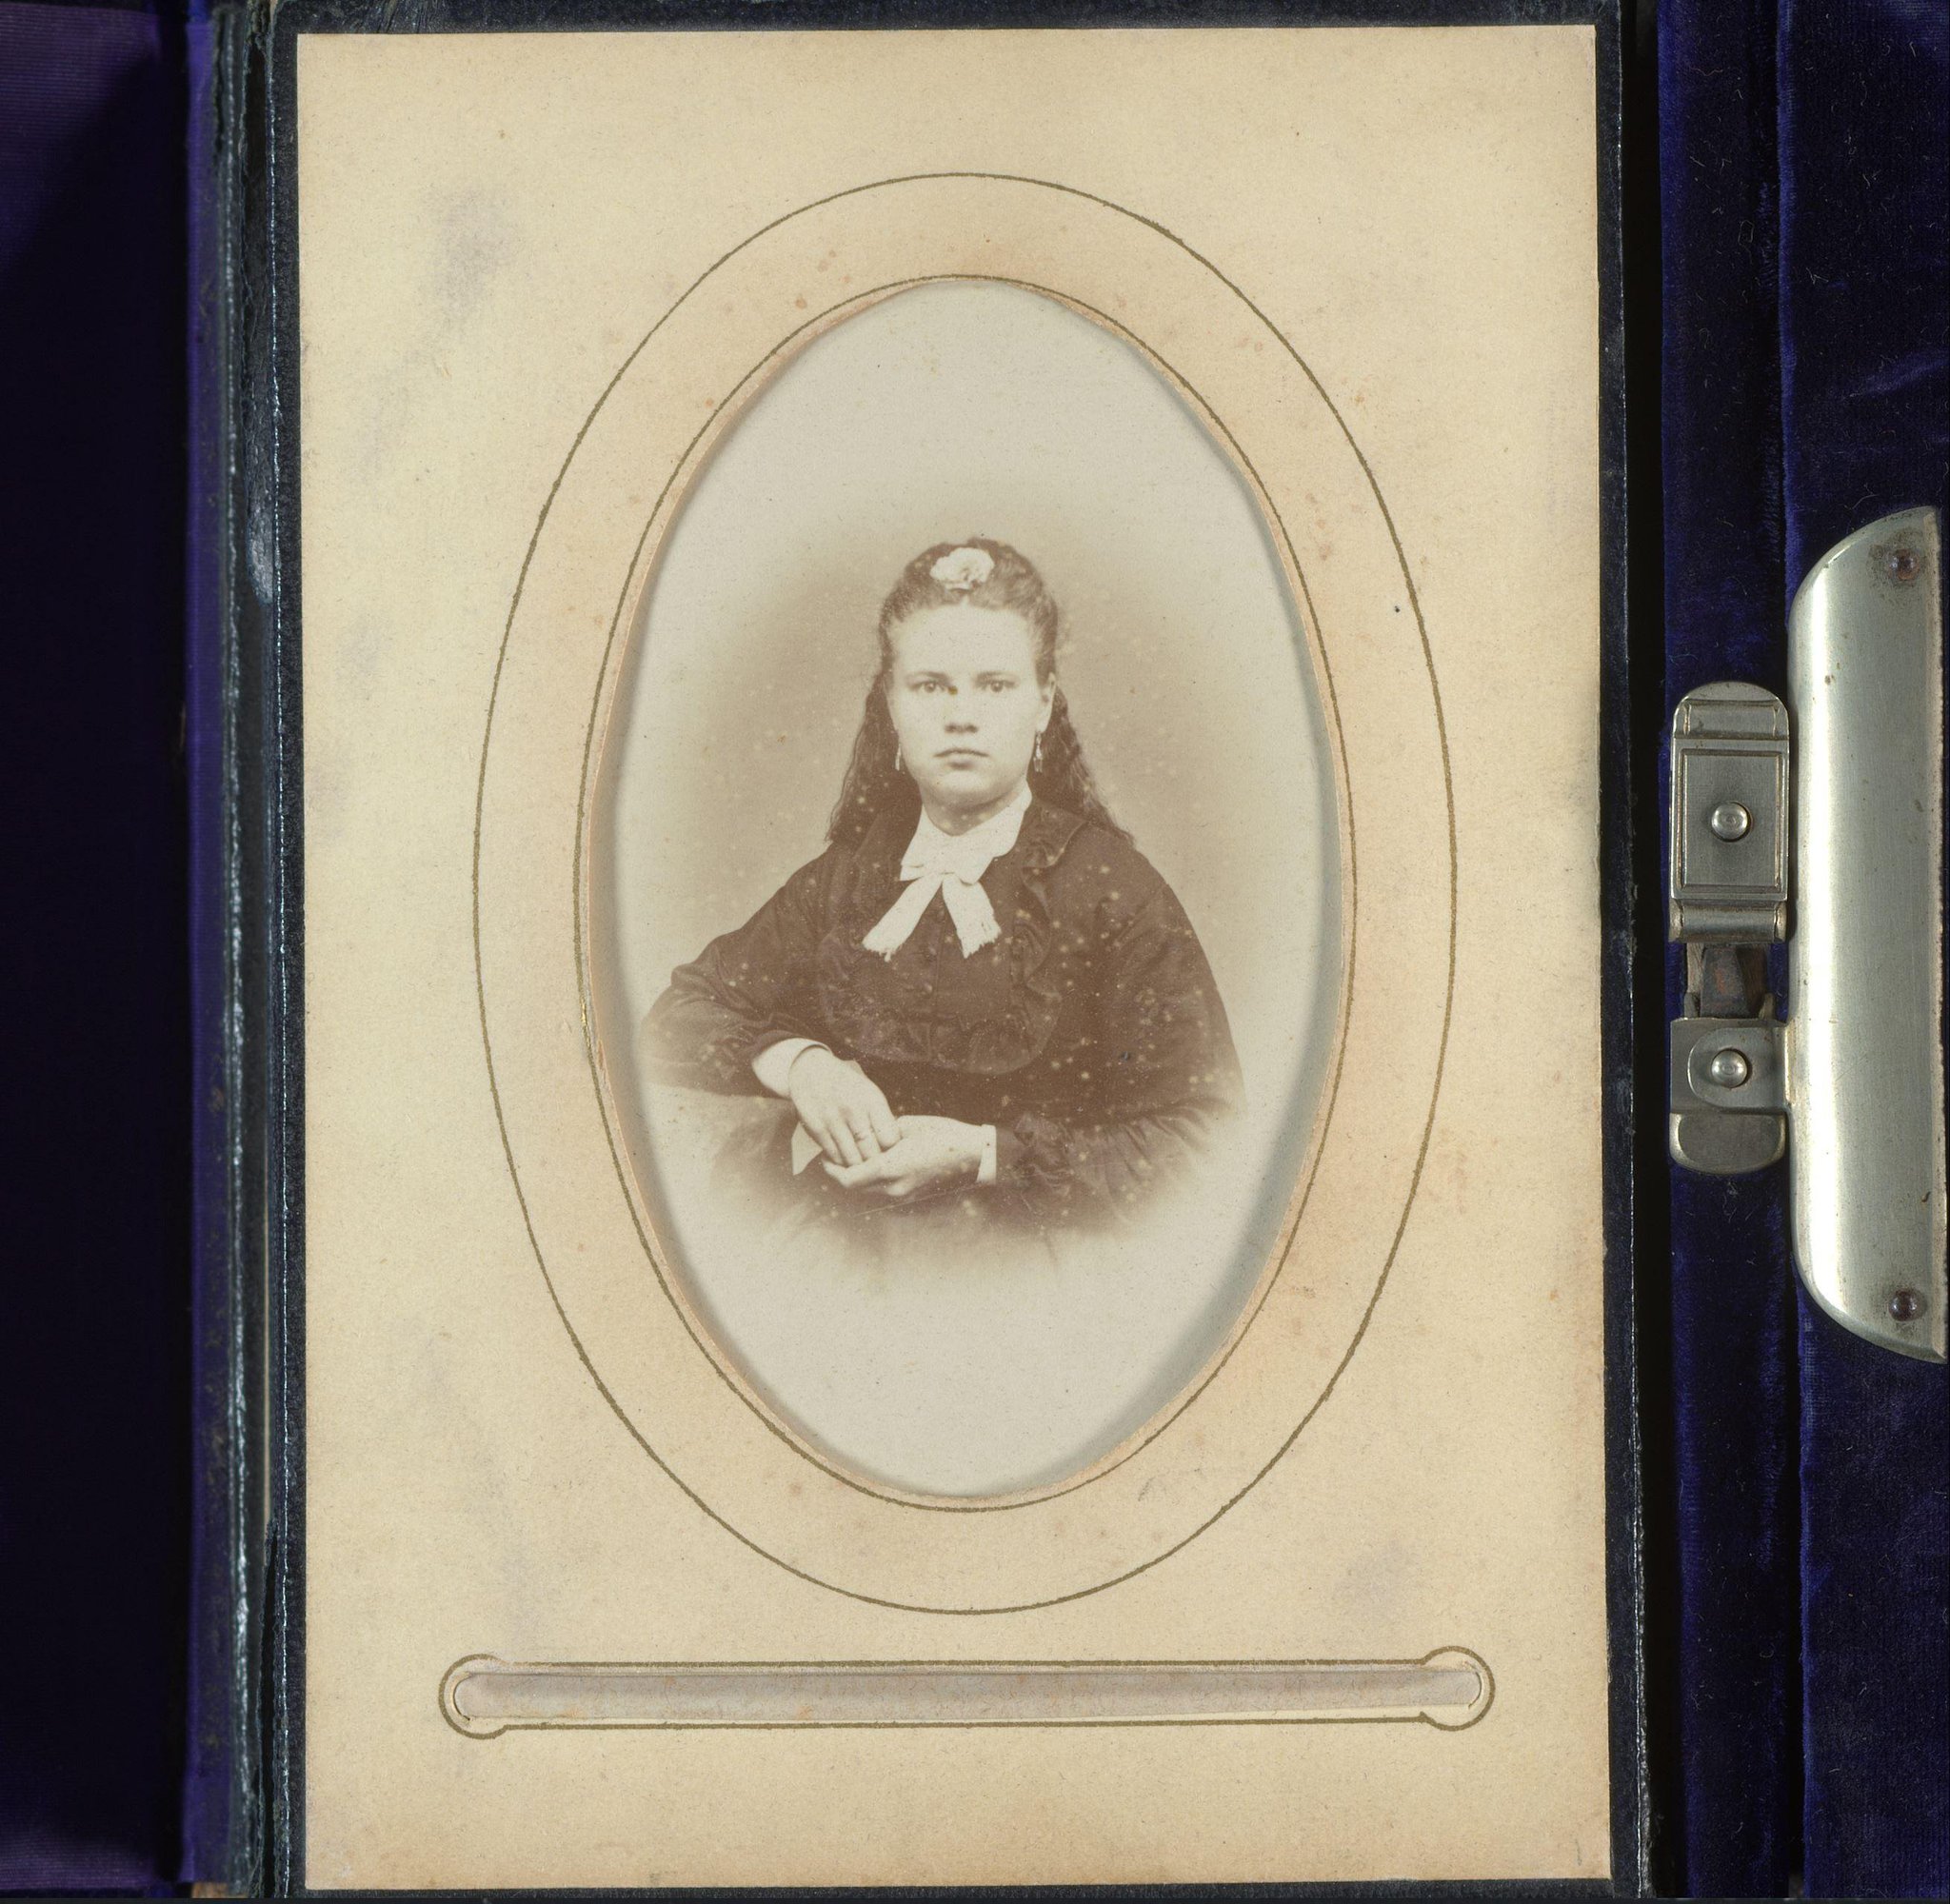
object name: photograph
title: Portret van een zittend meisje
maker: johannes frederik hulk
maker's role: draughtsman, painter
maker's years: 1829-1911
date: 1864-1901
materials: cardboard, photographic support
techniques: albumen print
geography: amsterdam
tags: sitting figure - aa - female human figure, historical persons - bb - woman, girl (child between toddler and youth)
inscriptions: inscription: ‘J. F. HULK/ DE REMBRANDT/ AMSTERDAM/ ROKIN, E 167’